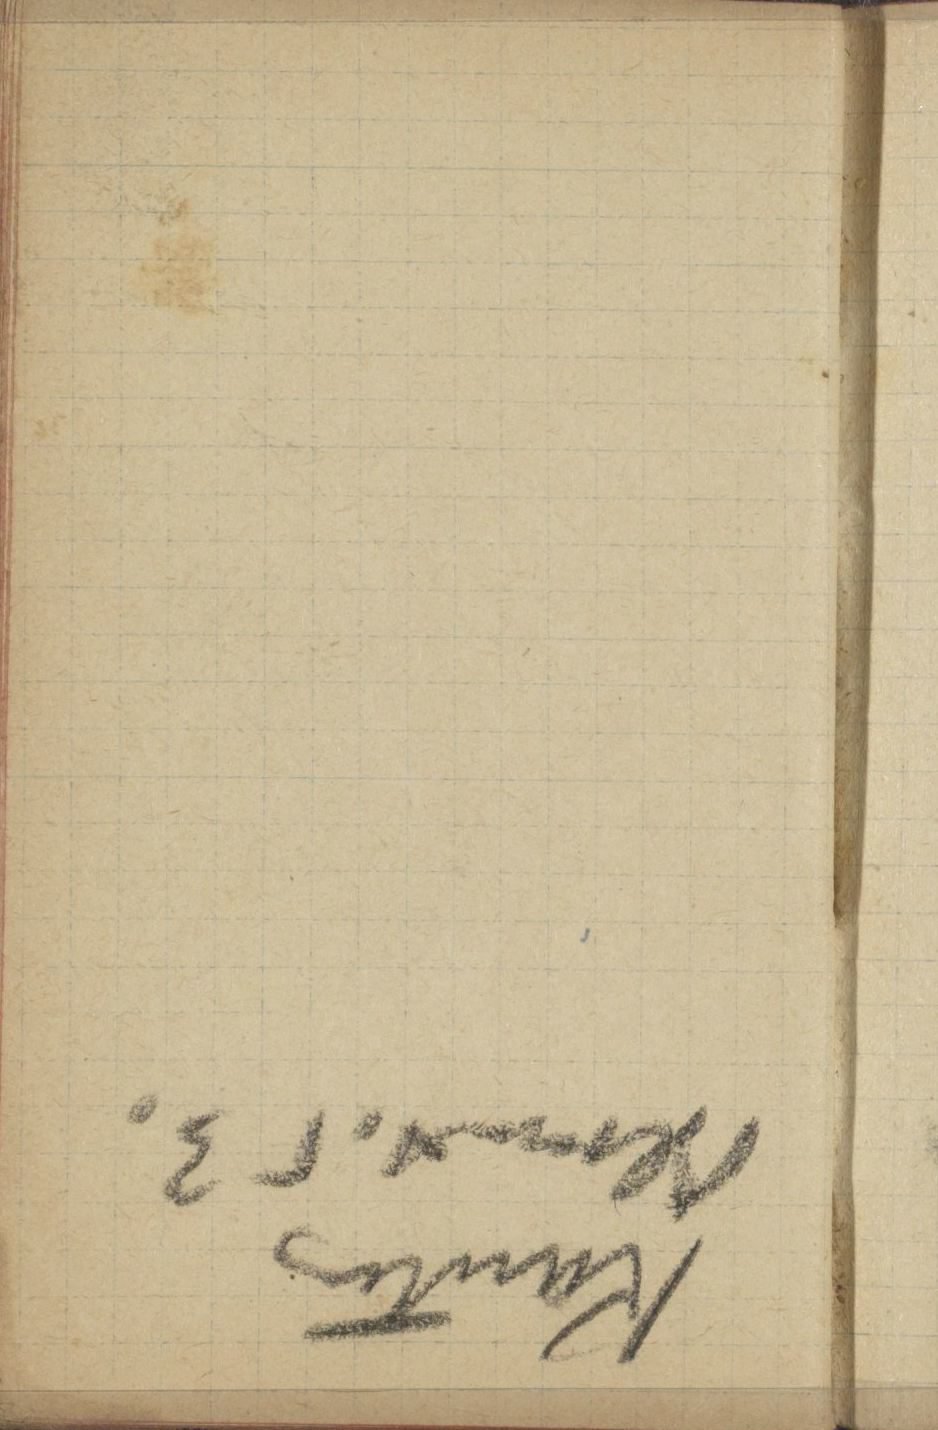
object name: sketchbook leaf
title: Annotatie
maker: george hendrik breitner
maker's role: draughtsman, painter, print maker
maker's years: 1857-1923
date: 1896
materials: chalk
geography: amsterdam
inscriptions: annotation: ‘[...]’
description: Pagina 55 uit een schetsboek met 29 bladen.